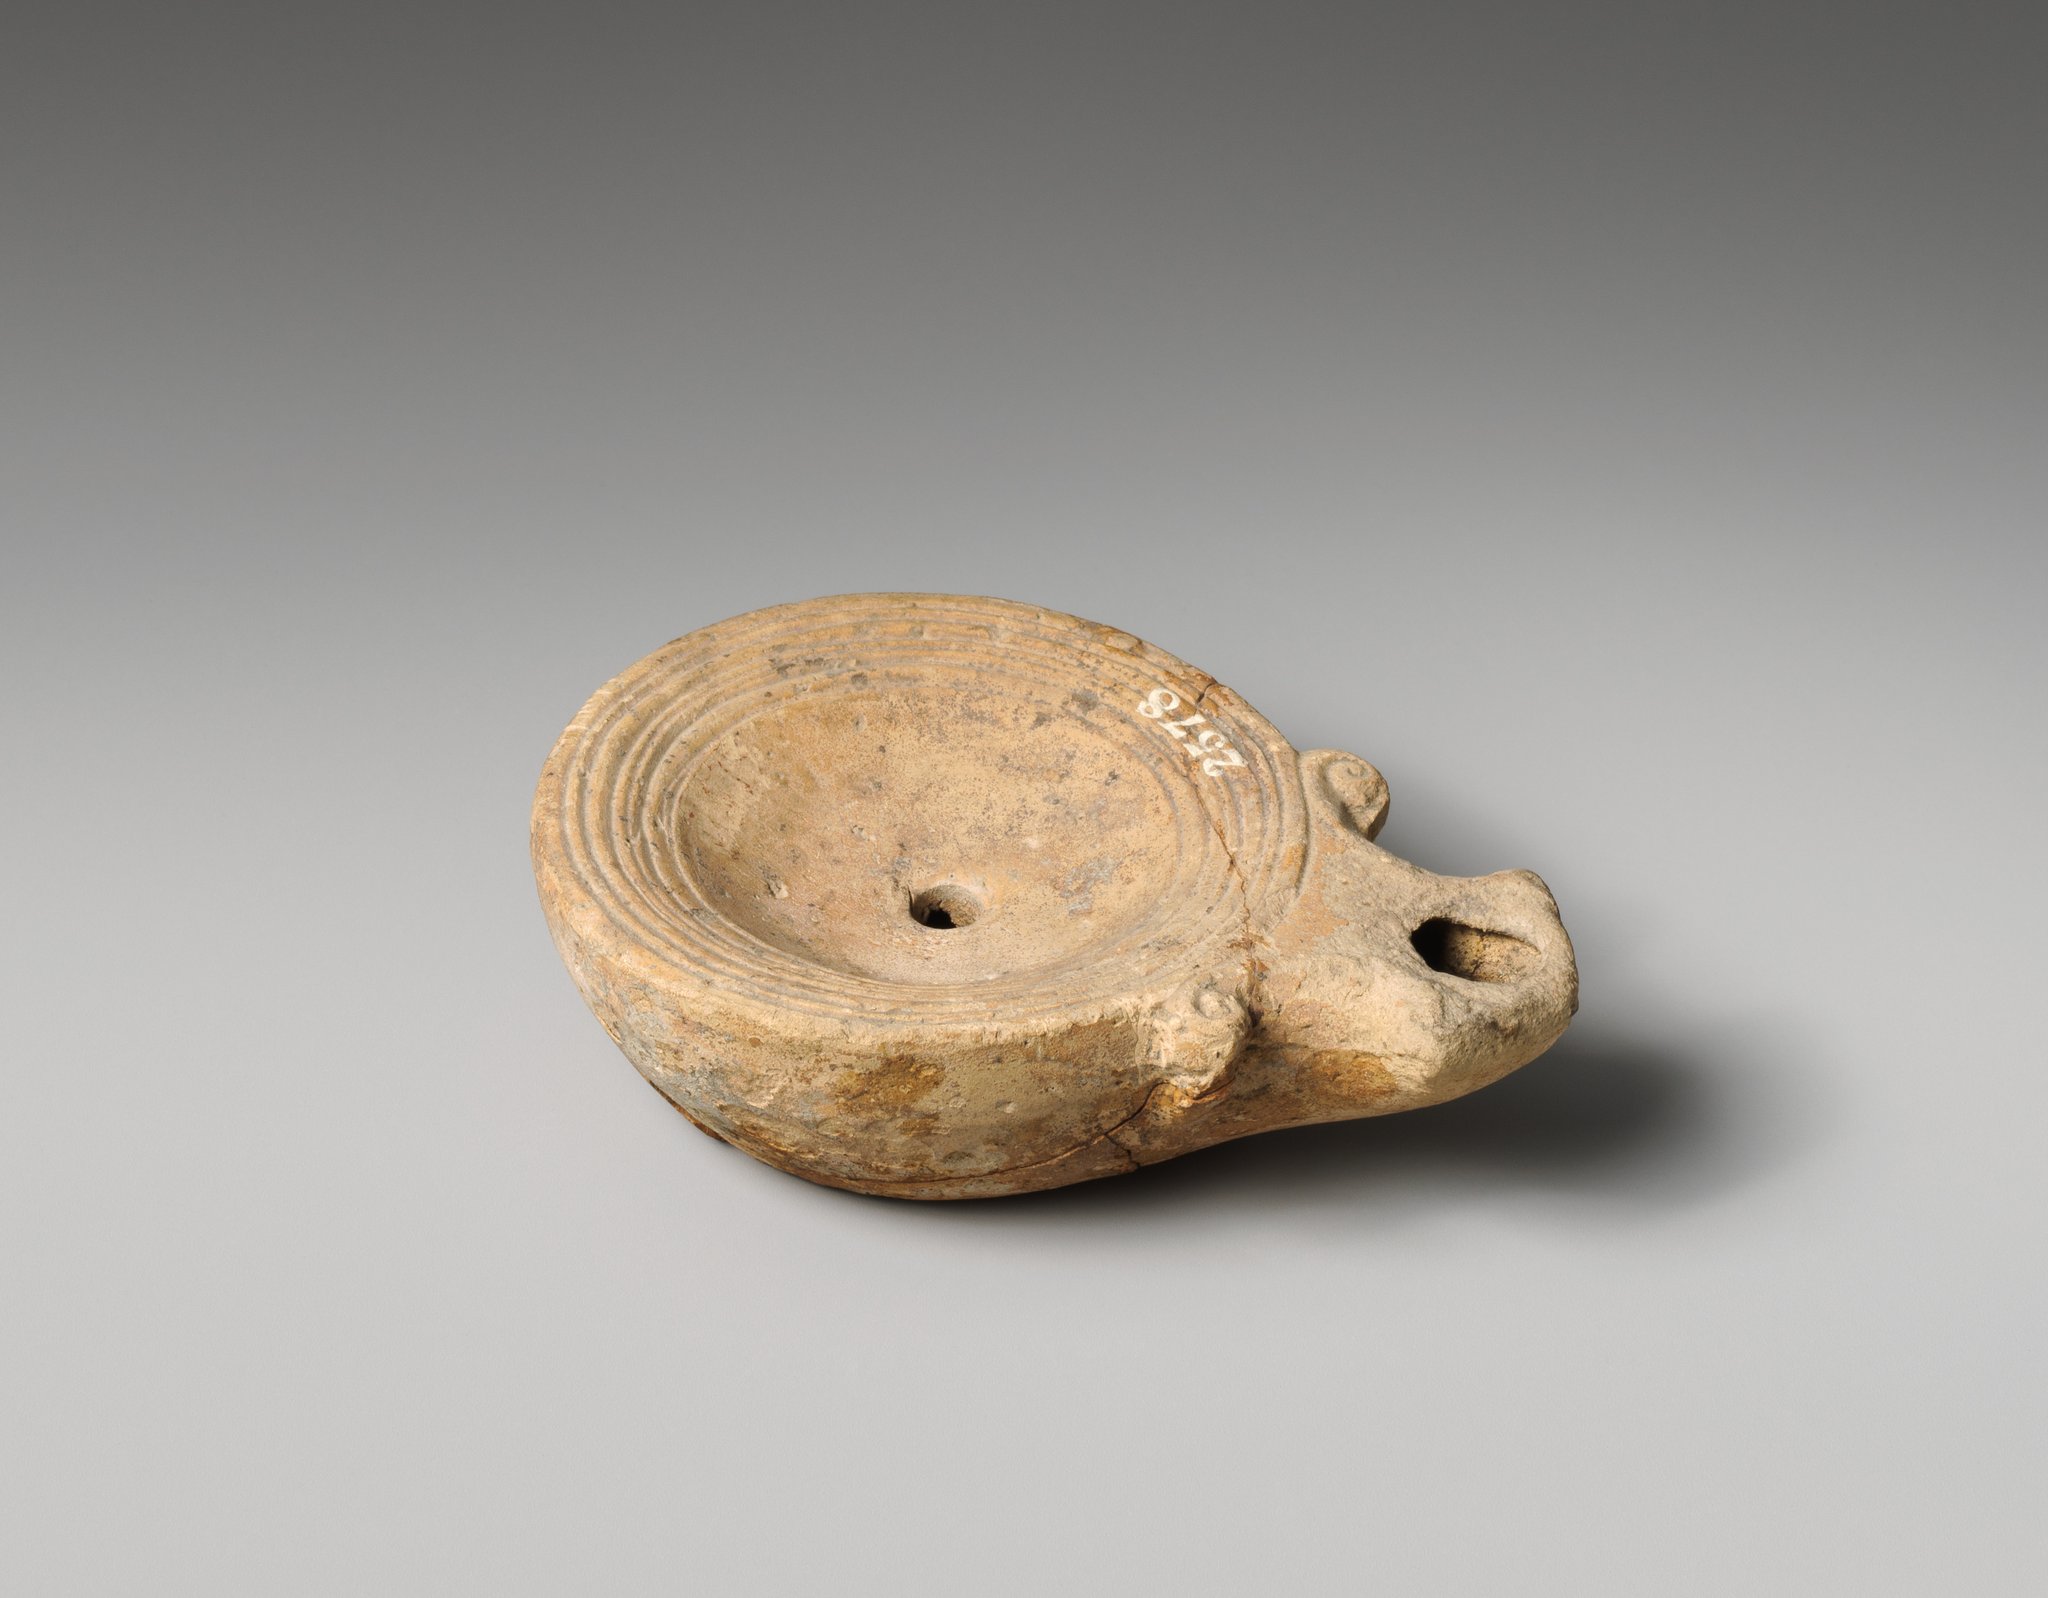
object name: lamp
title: Terracotta oil lamp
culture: roman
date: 100 BCE-100 CE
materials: terracotta